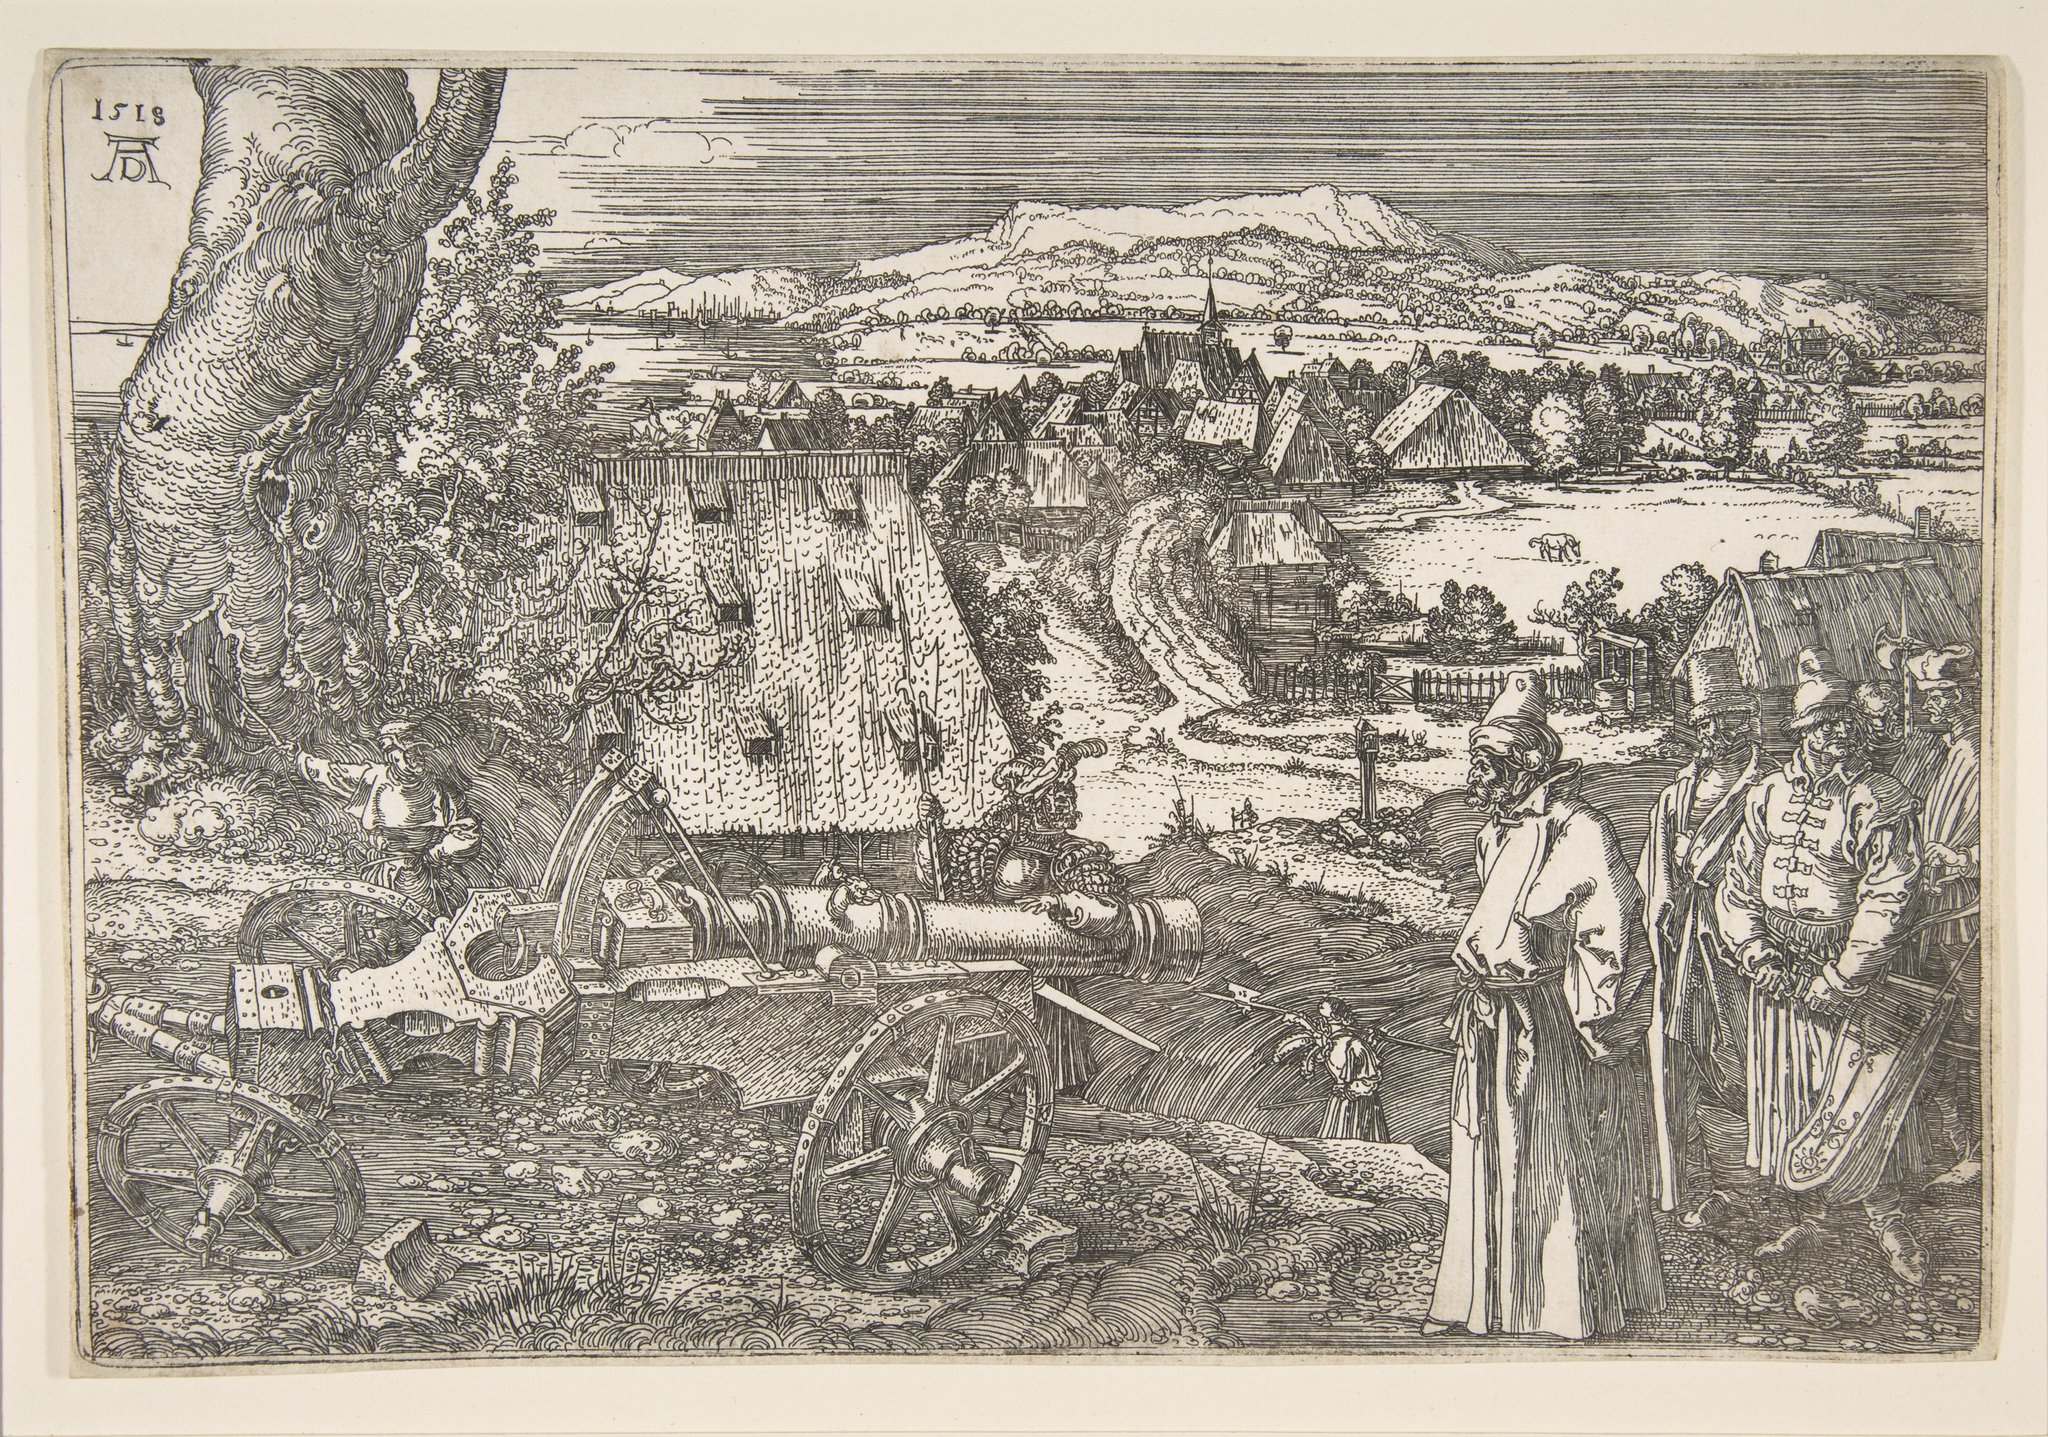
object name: print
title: Landscape with a Cannon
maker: albrecht dürer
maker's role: artist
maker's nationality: german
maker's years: 1471-1528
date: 1518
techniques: etching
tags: houses,cannons,men,landscapes